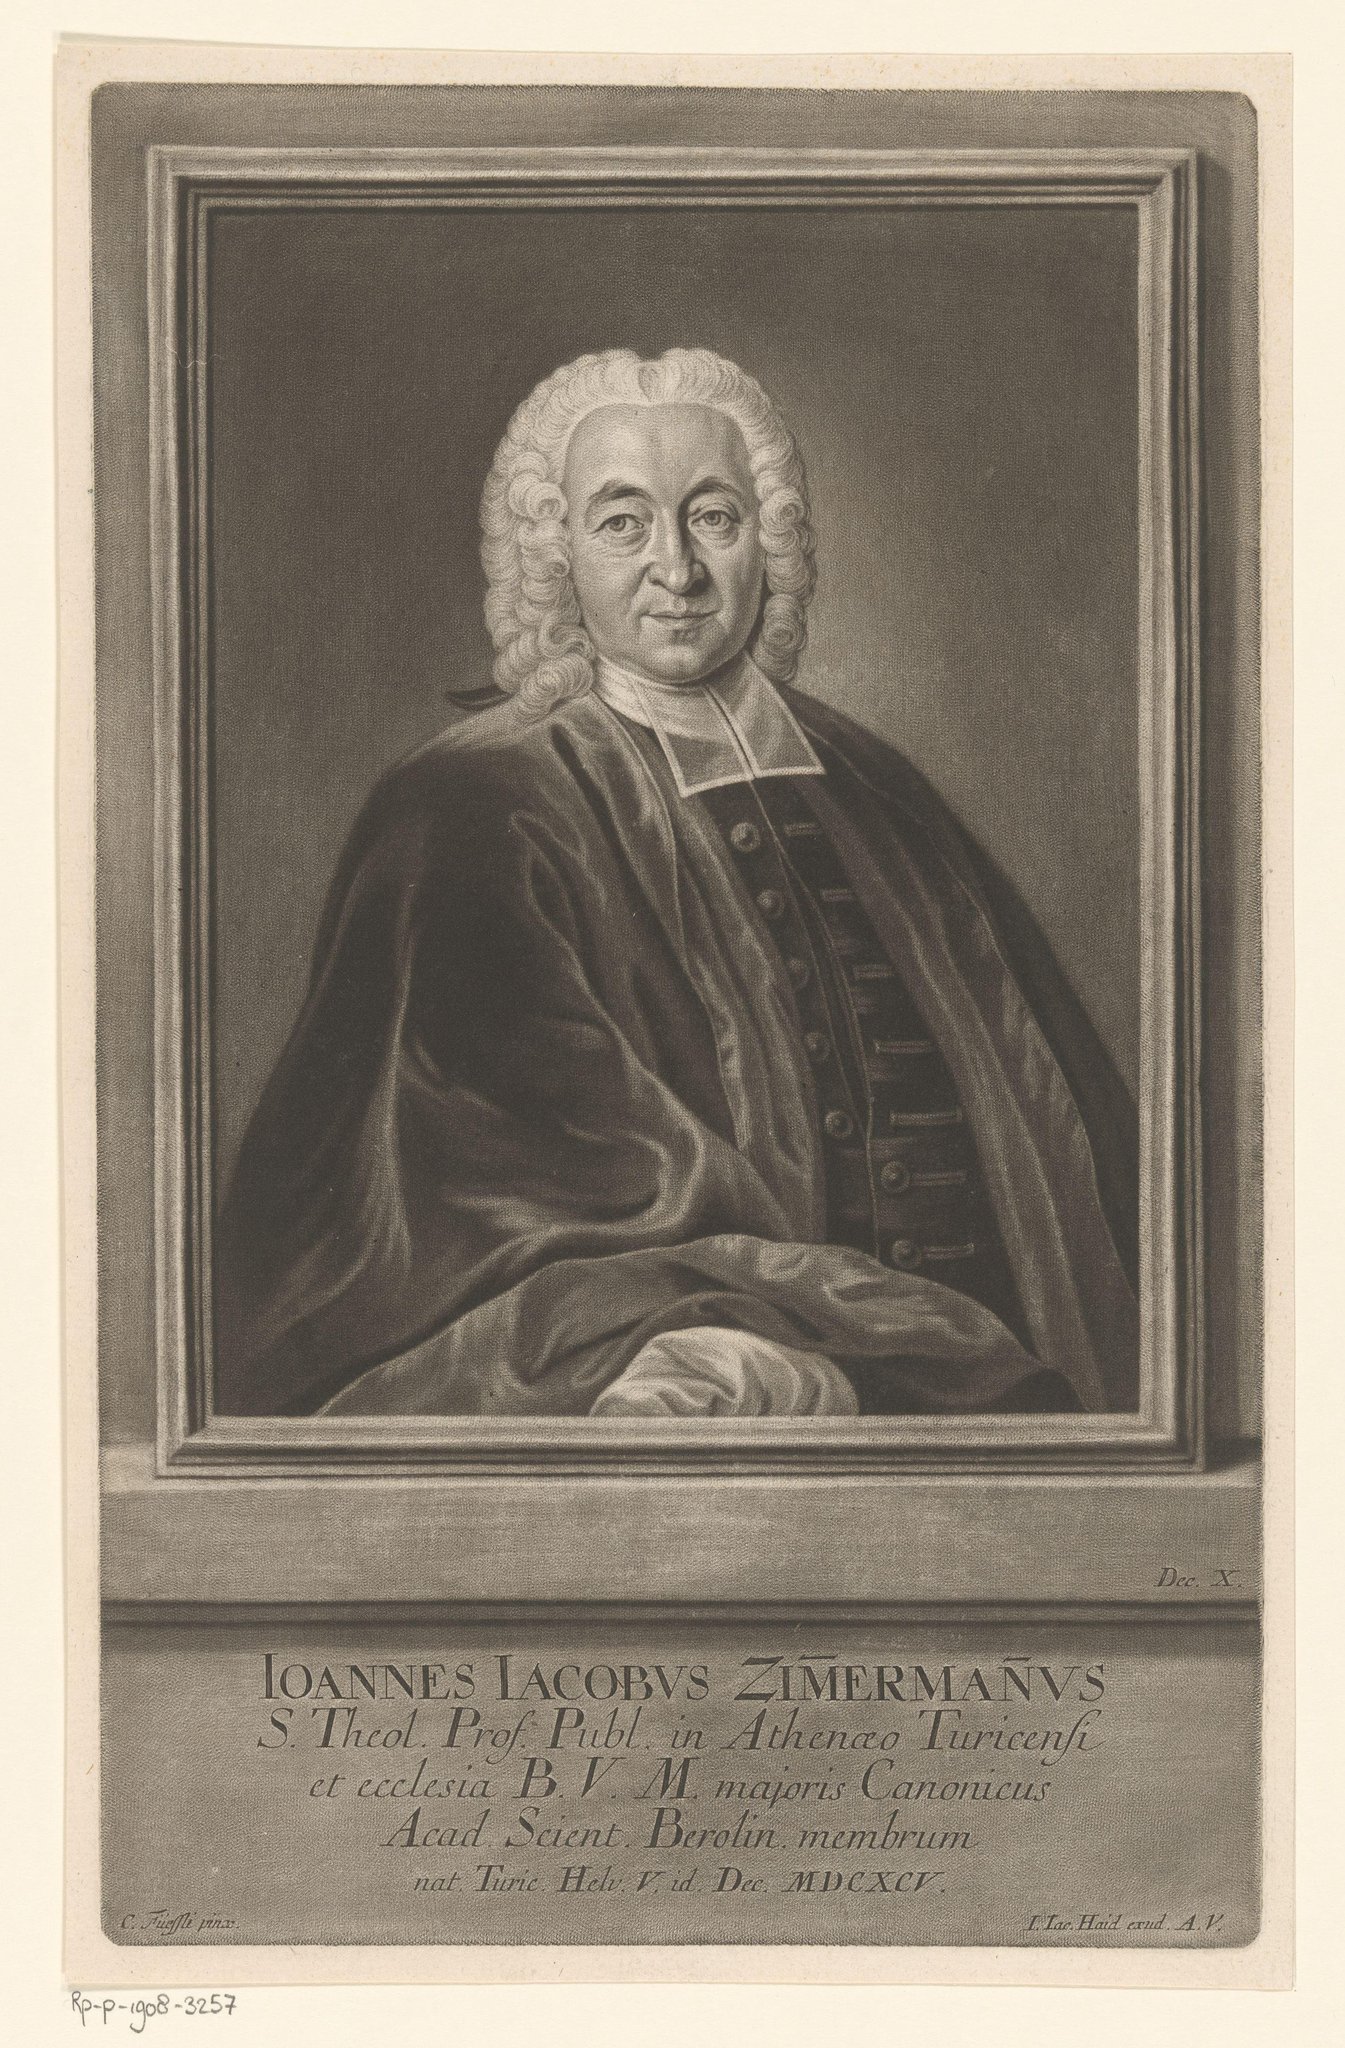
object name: print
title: Portret van Johannes Jacob Zimmermann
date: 1755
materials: paper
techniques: mezzotint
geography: augsburg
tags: historical persons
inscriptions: collector's mark: Lugt 2228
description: Prent gebruikt voor: Brucker, Jacob. Bildersal heutiges Tages lebender und durch Gelahrheit berühmter Schrifftsteller. Augsburg: Johann Jacob Haid, 1755.